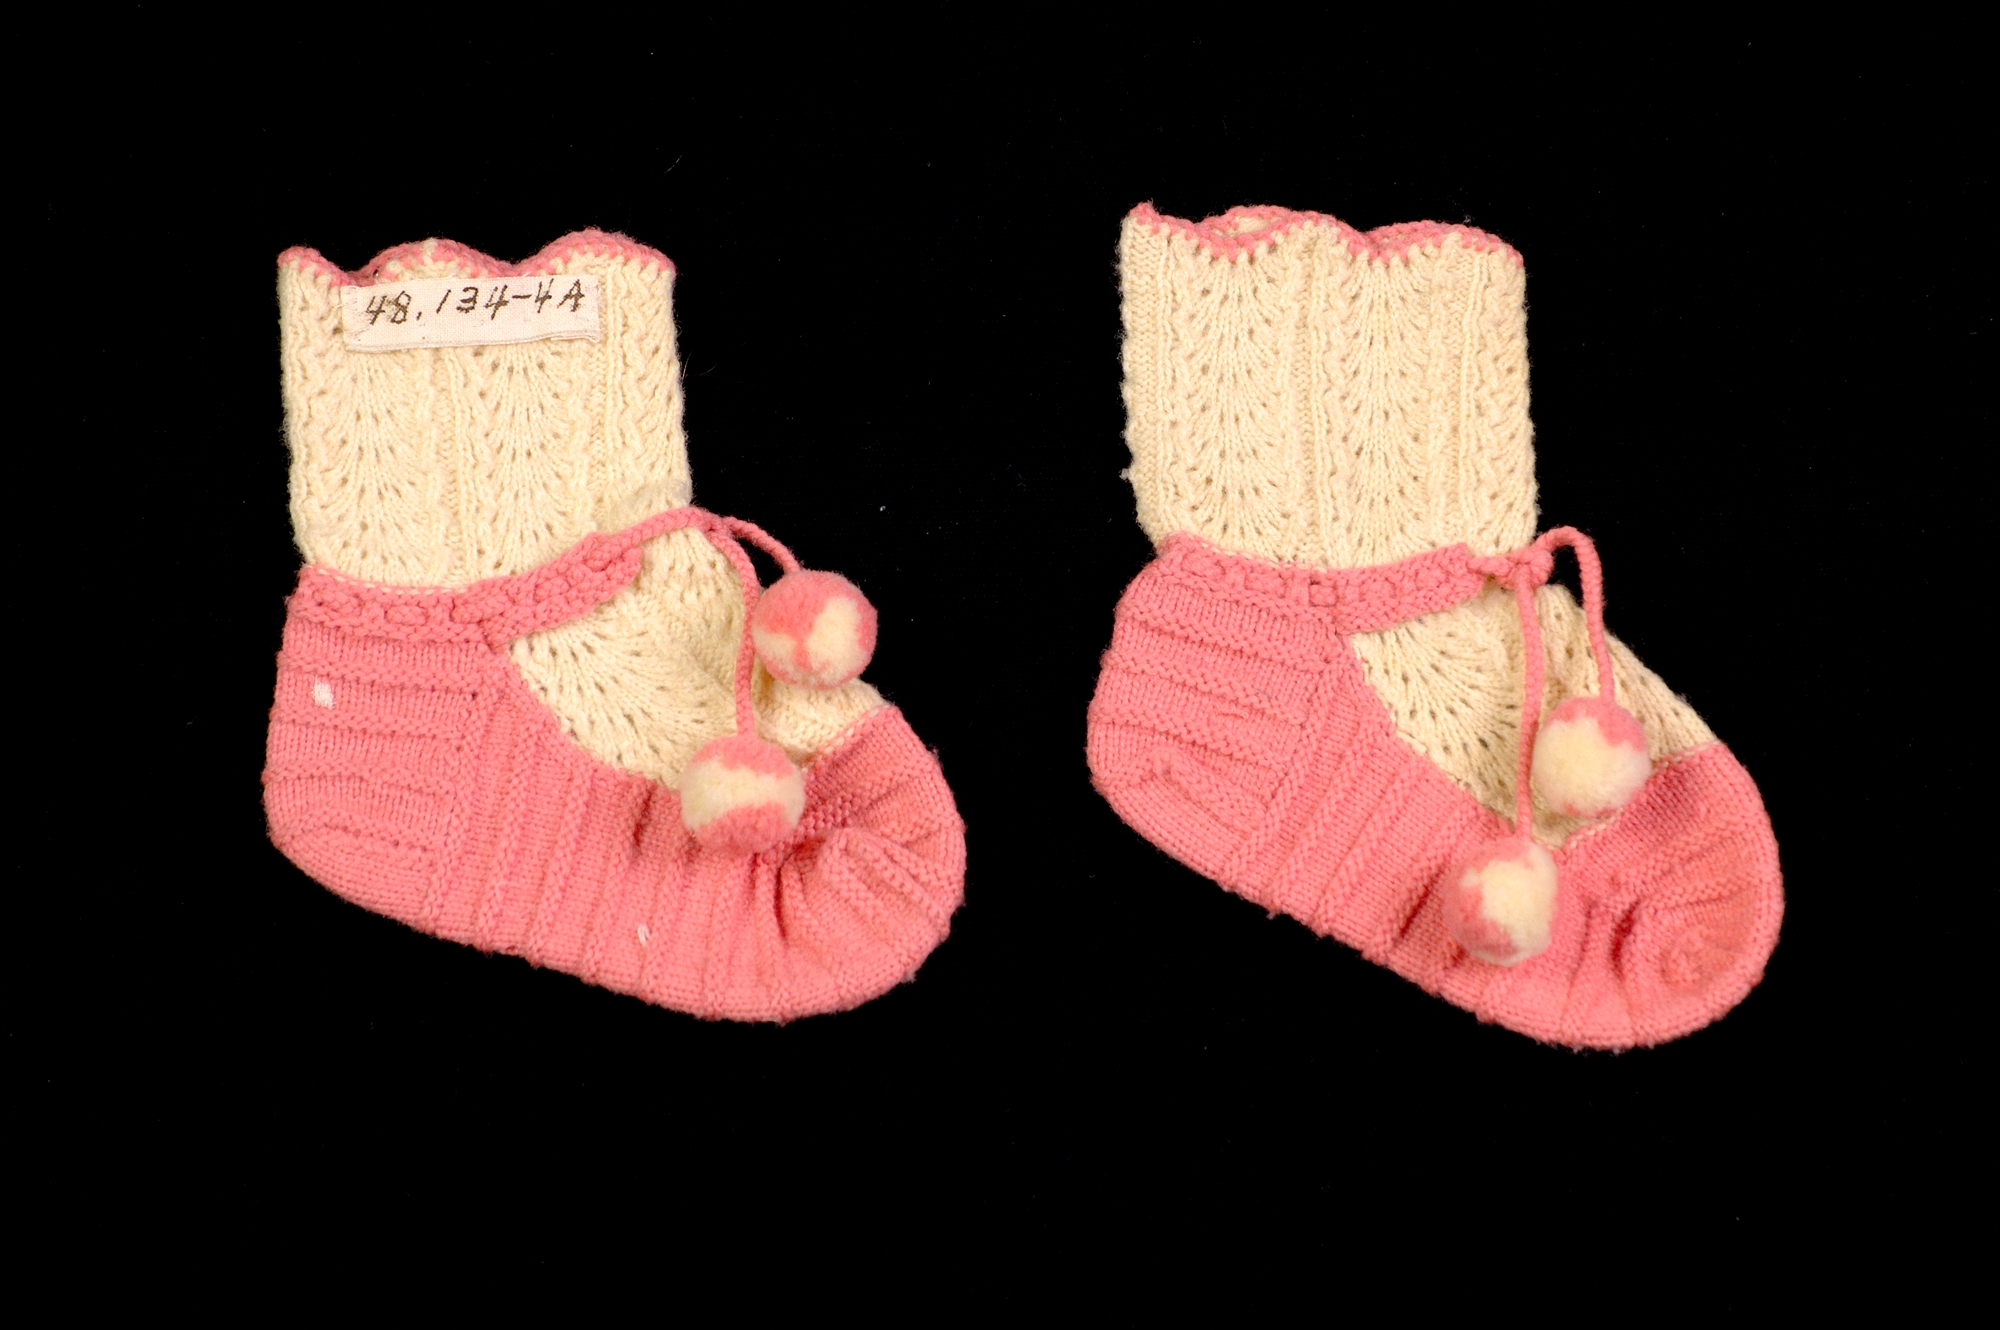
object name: bootee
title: Bootees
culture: american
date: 1860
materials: wool